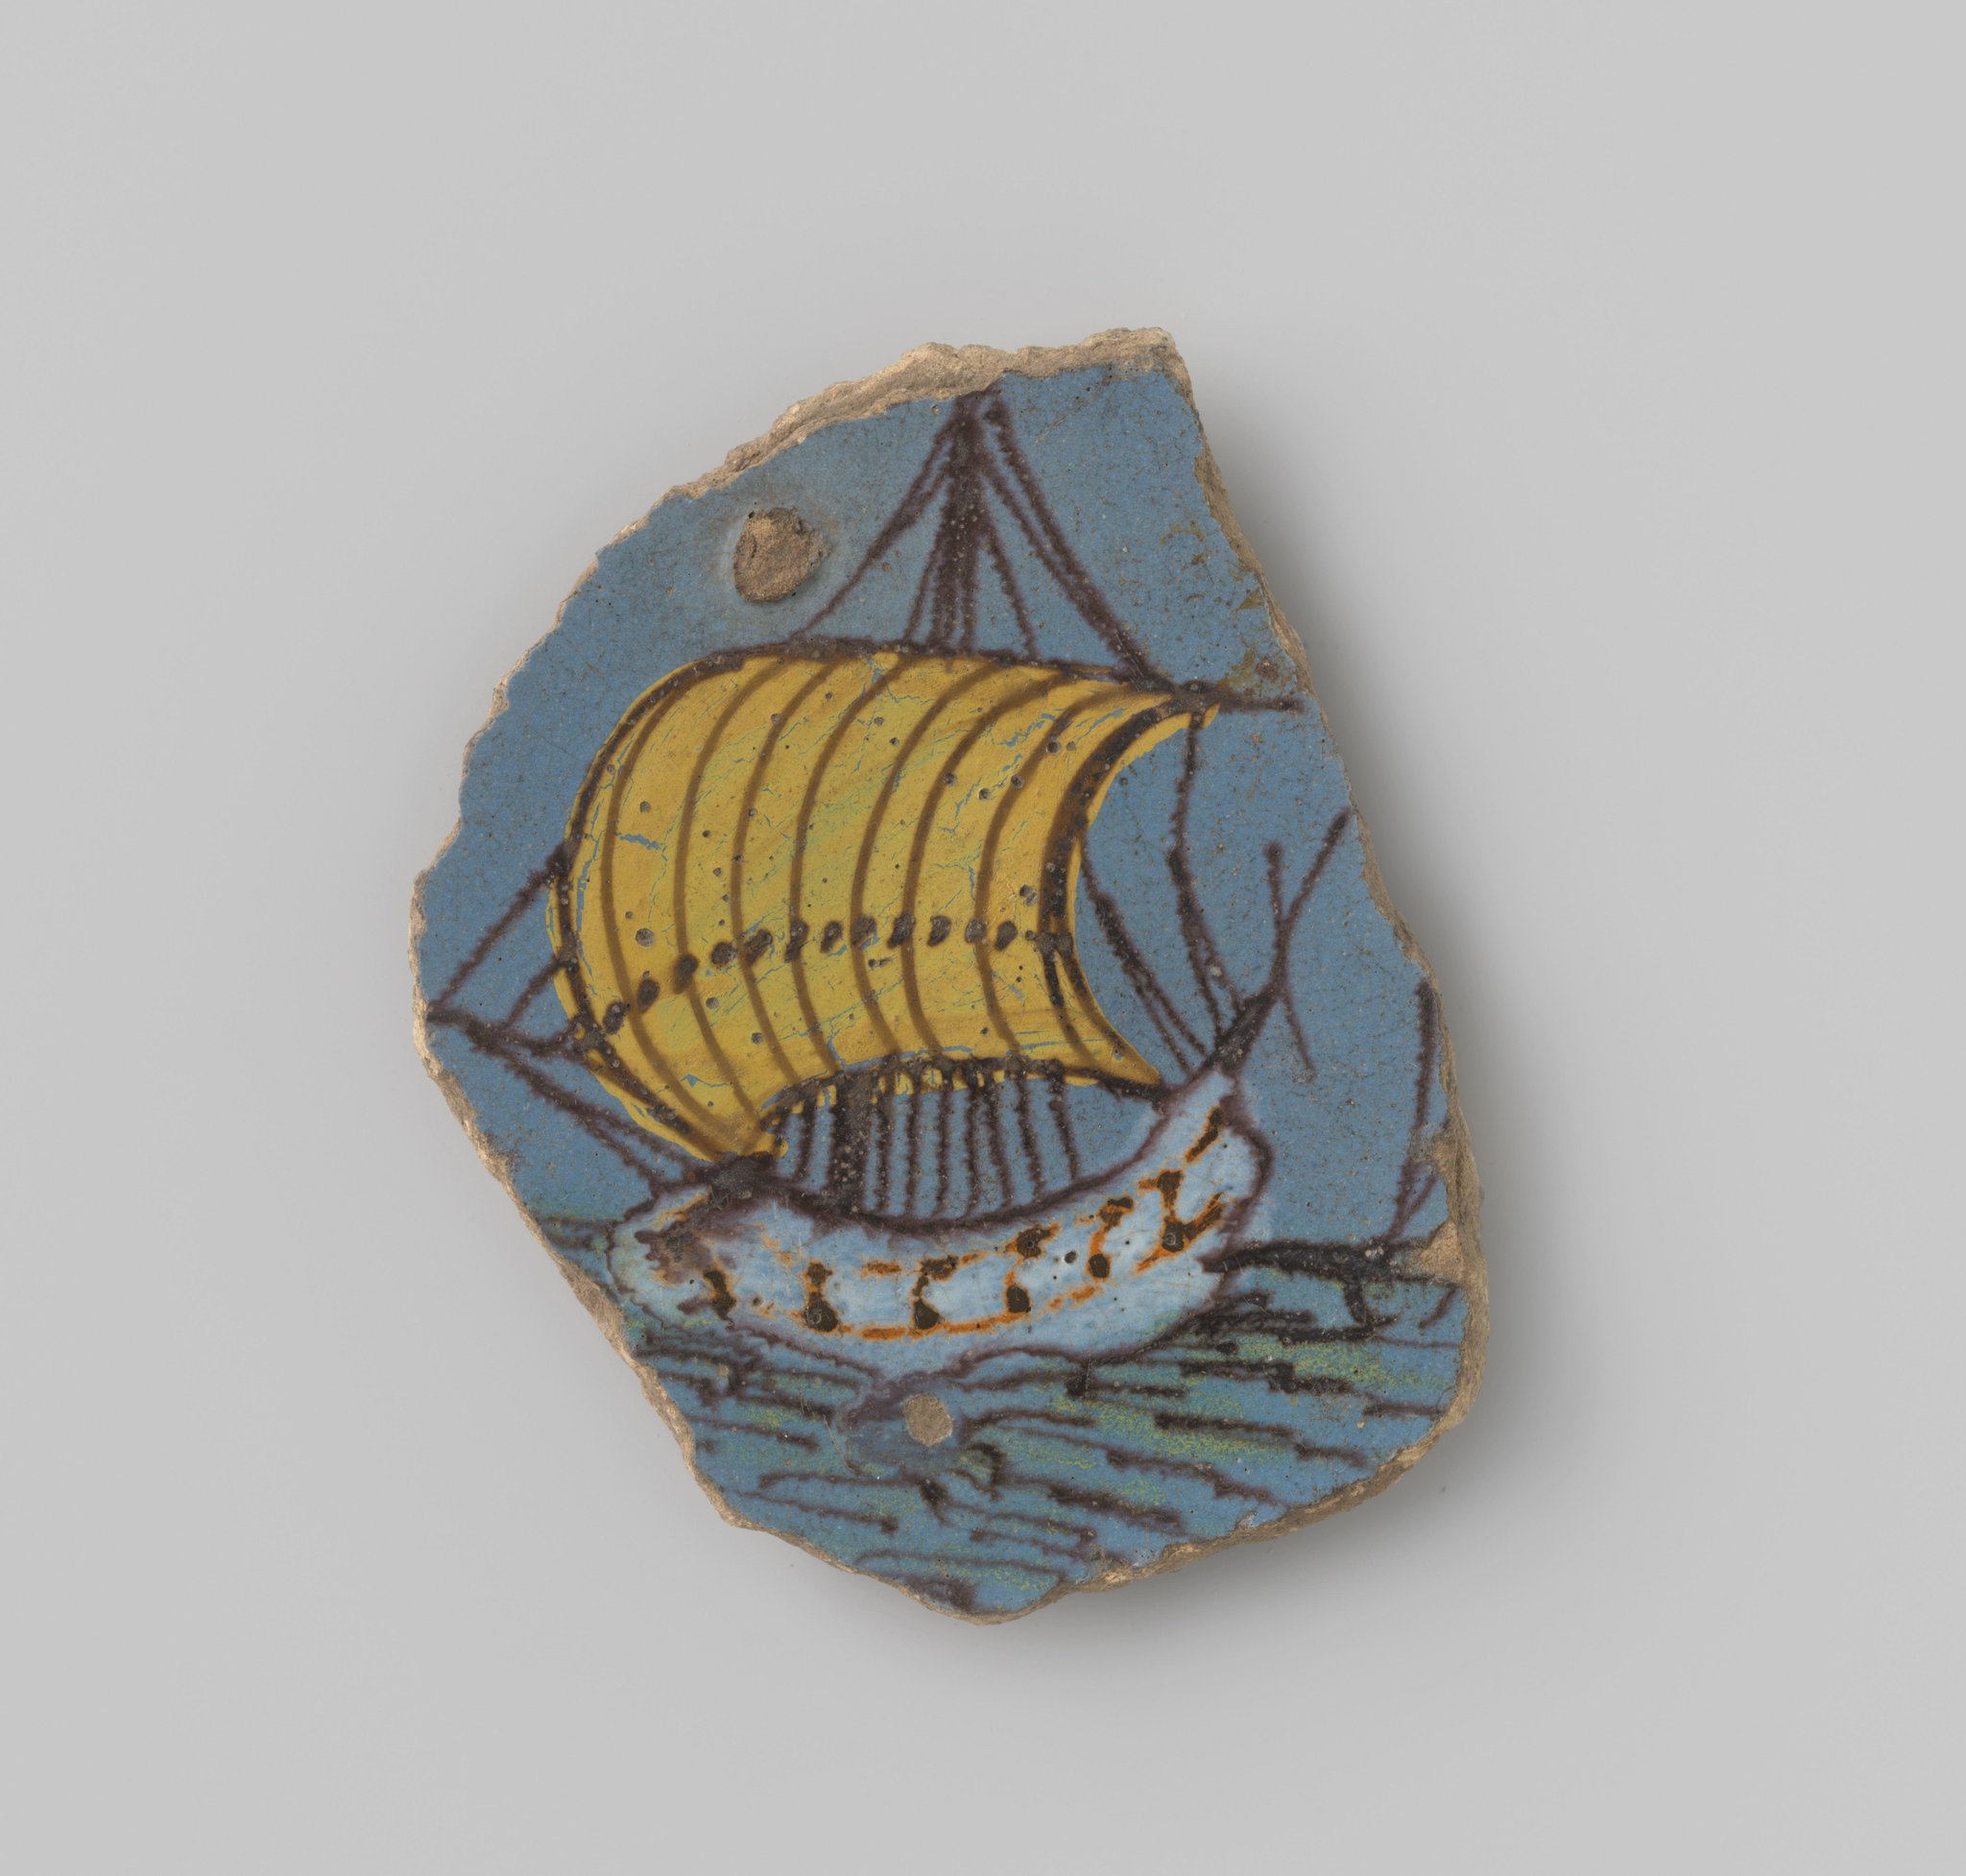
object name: sherd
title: Schotelscherf van geelbakkend aardewerk, voorzien van blauw glazuur aan de bovenzijde, waarop op het plat een schildering van een schip in bruin, met witte romp en geel zeil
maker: Anonymous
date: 1500-1699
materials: earthenware, glaze